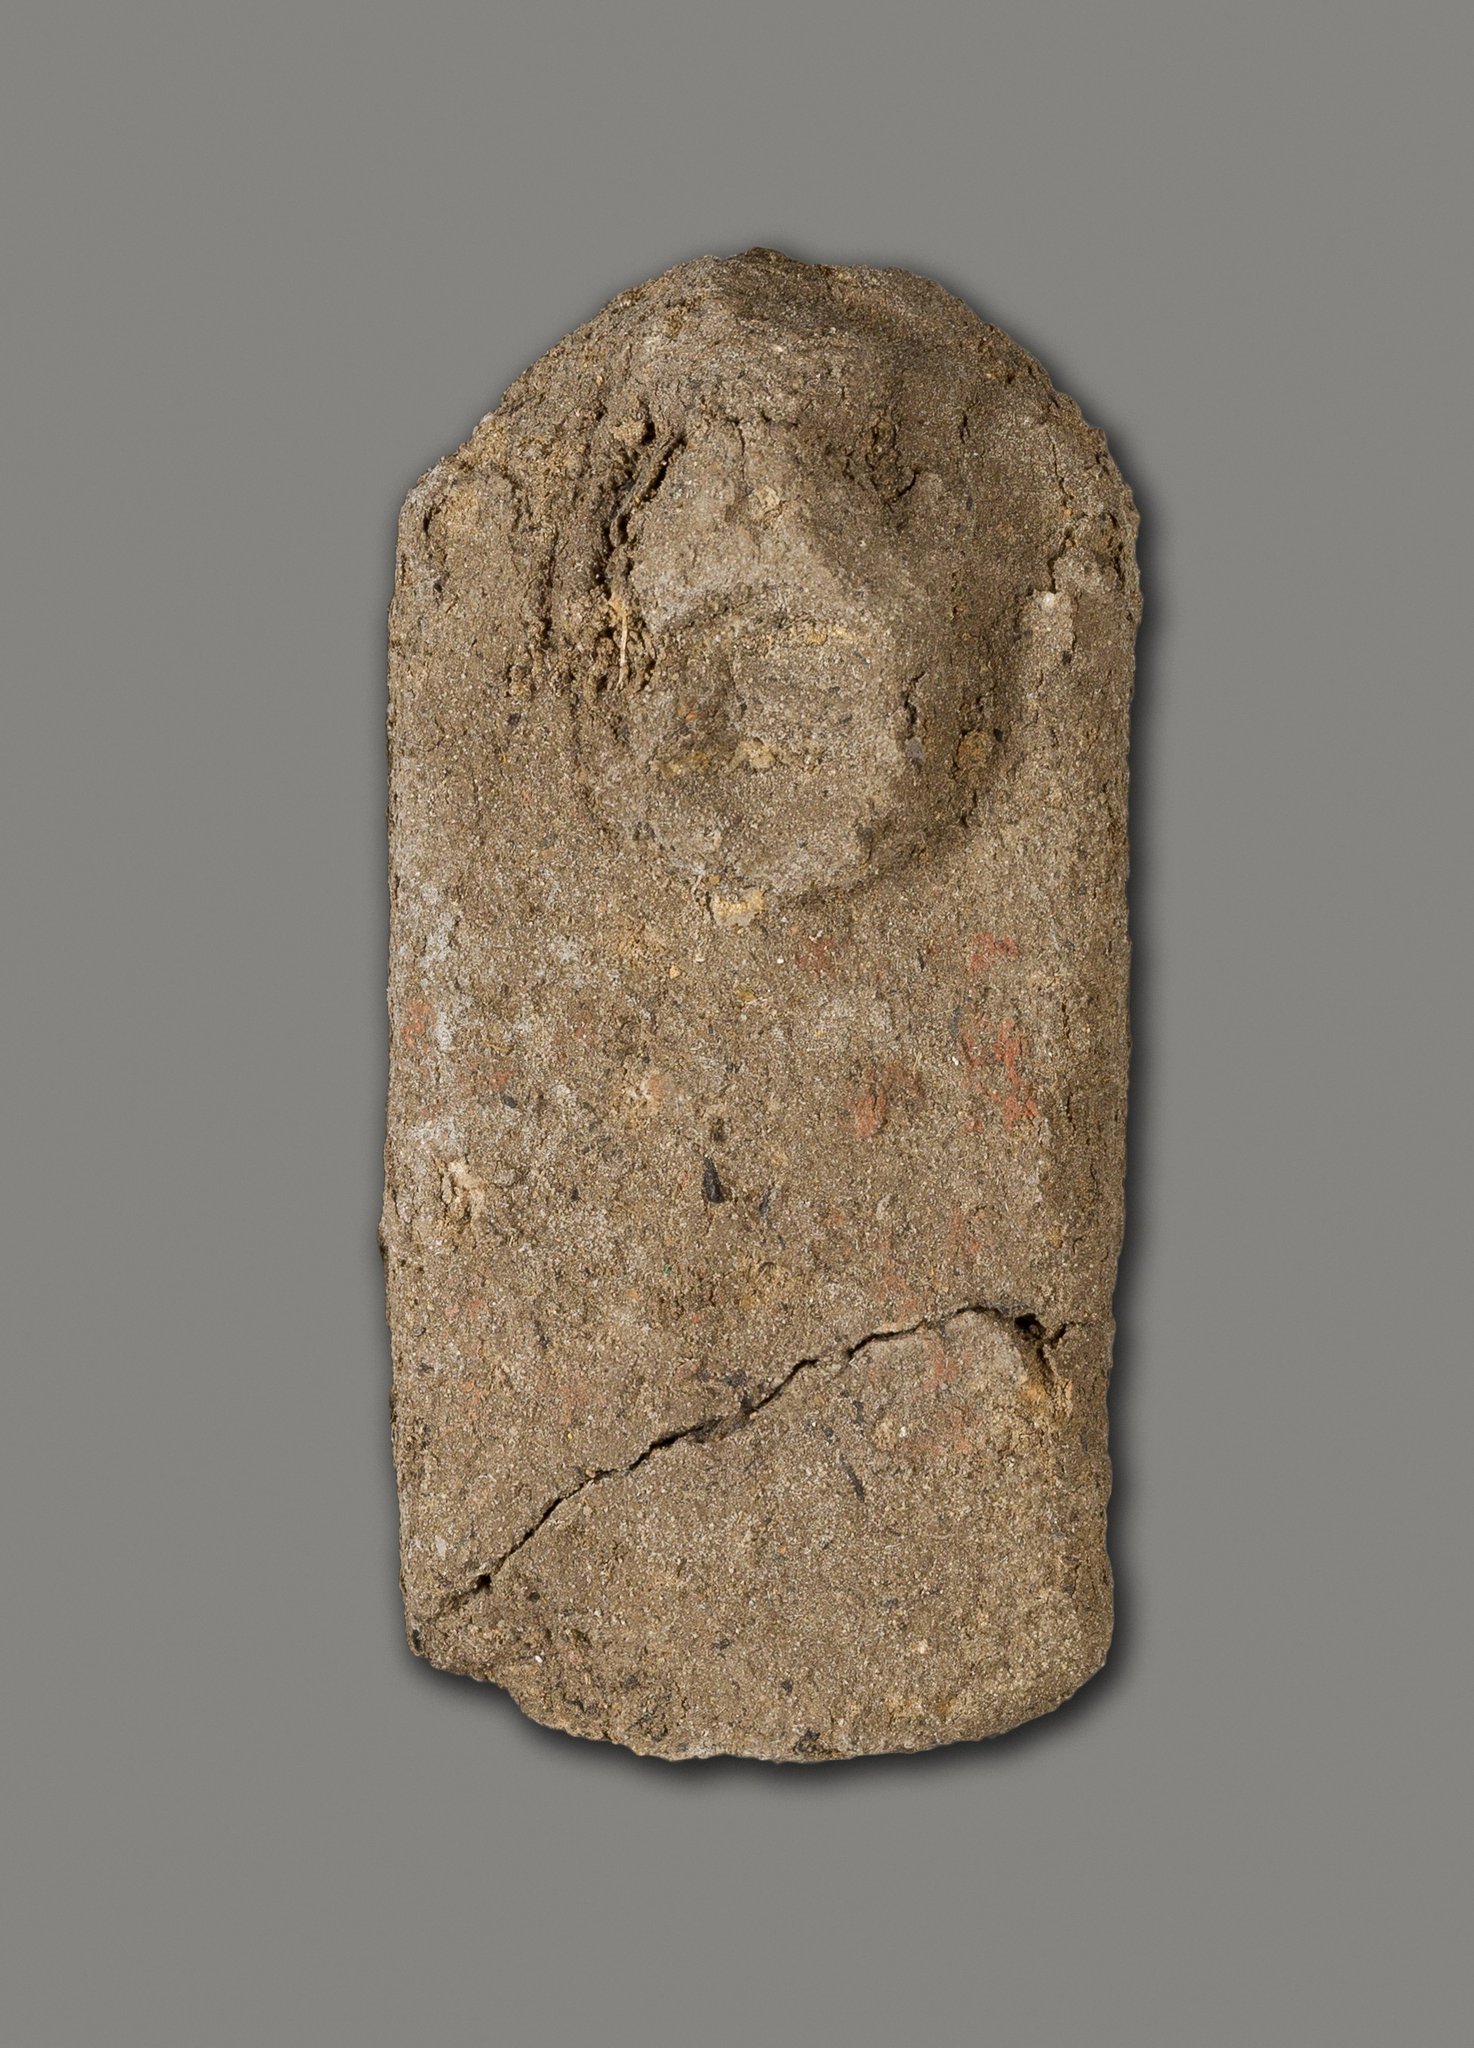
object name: figure, magical, execration, tablet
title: Magical Figure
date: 1802-1550 BCE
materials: clay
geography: egypt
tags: faces